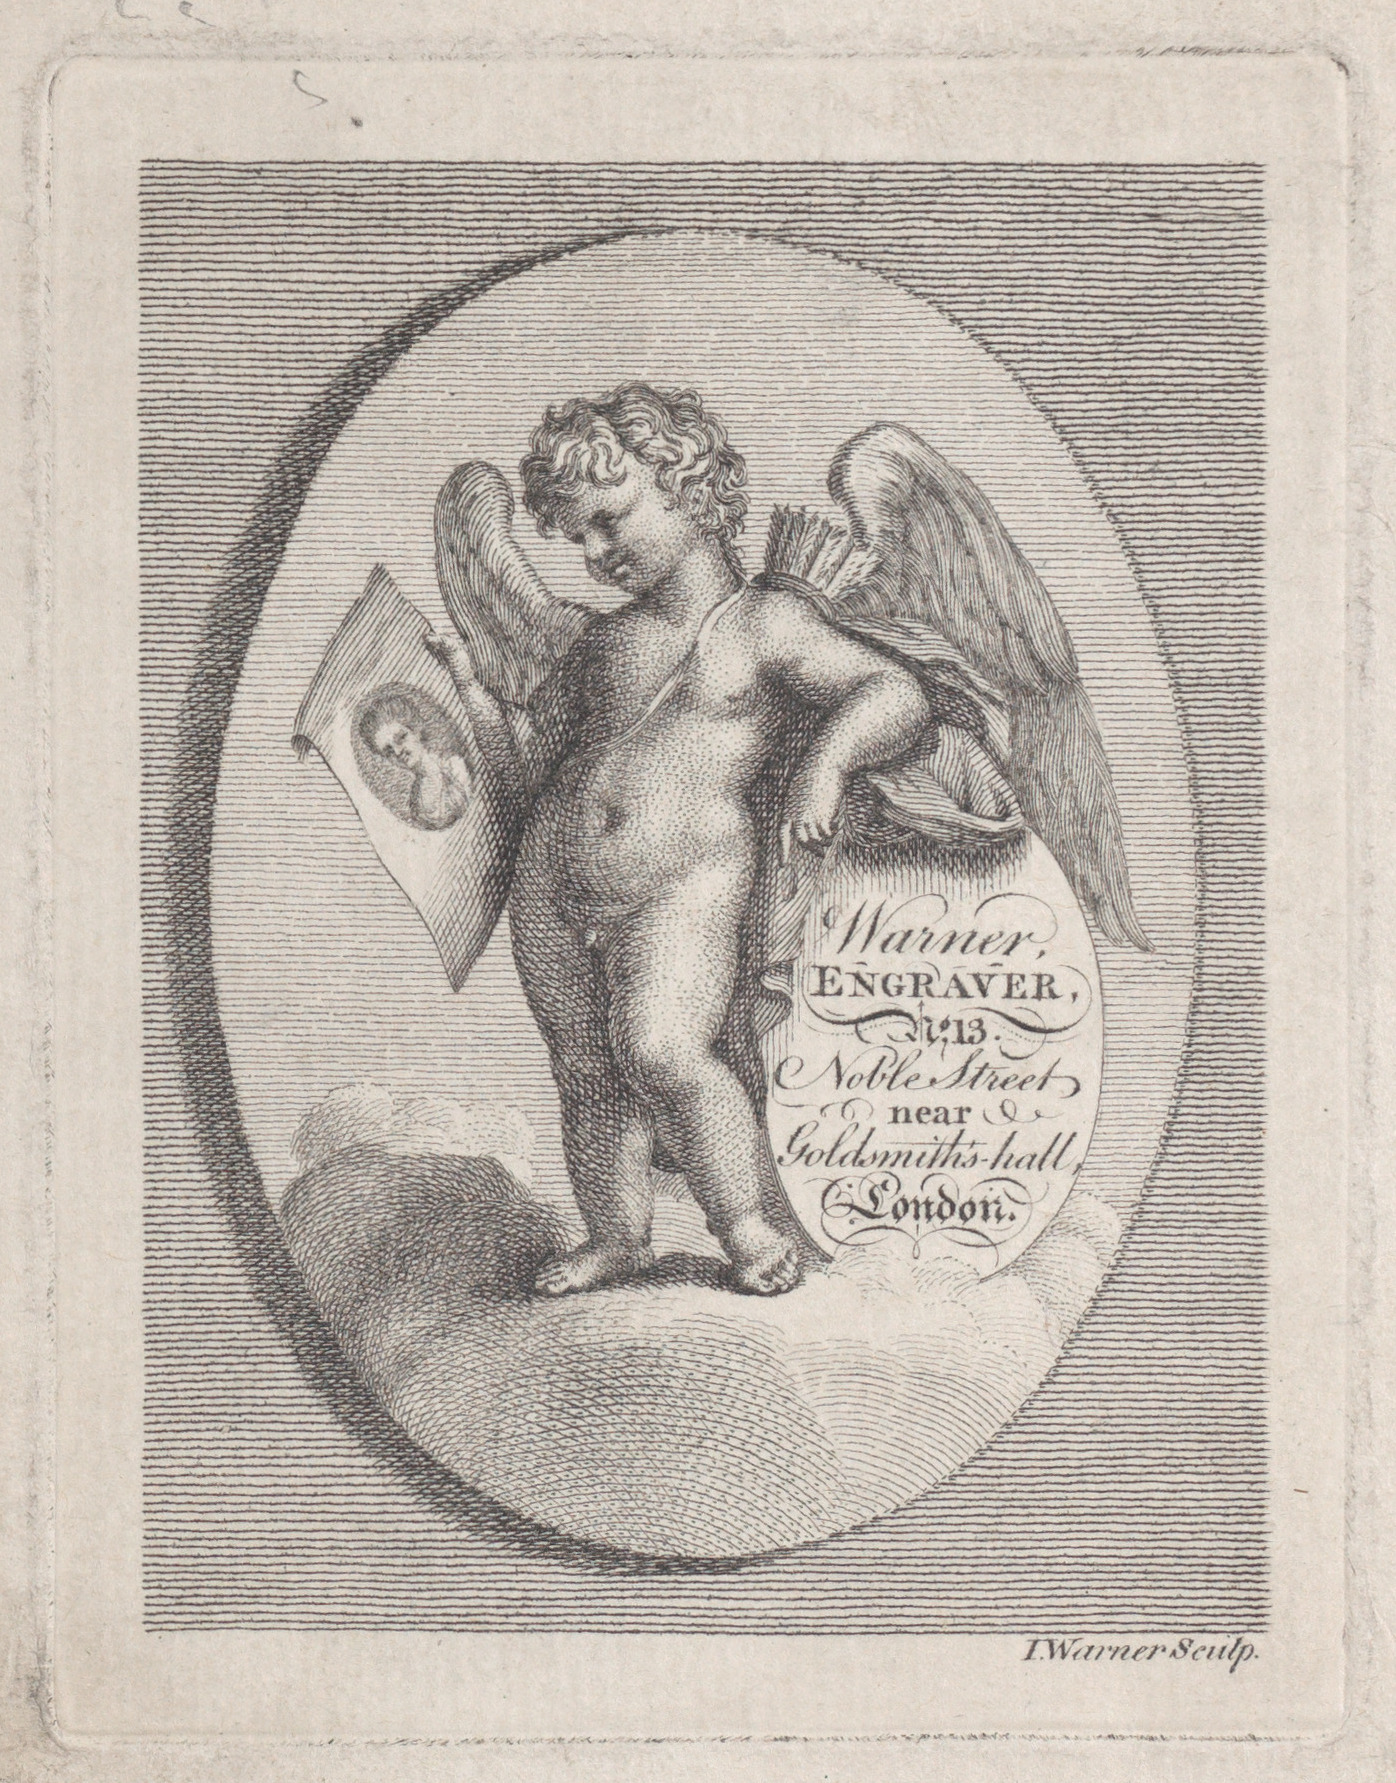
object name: print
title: Trade card for I. Warner, Engraver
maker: Anonymous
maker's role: artist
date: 1701-1800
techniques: engraving